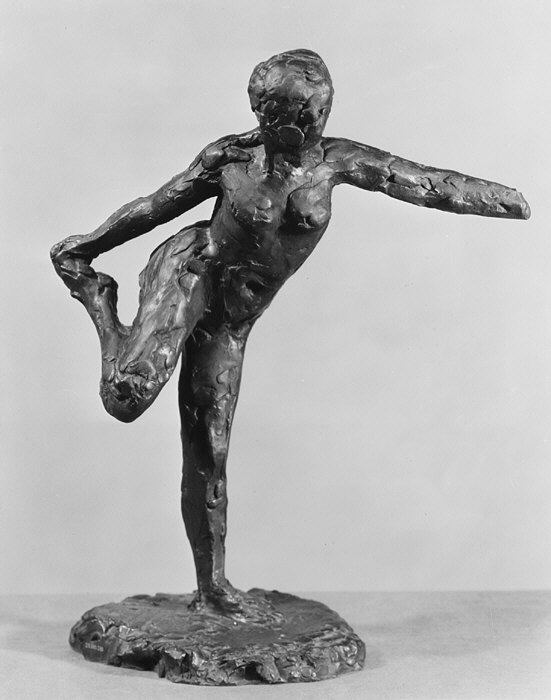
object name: statuette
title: Dancer Holding her Right Foot in Her Right Hand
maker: edgar degas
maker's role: artist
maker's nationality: french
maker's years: 1834-1917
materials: bronze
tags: female nudes,dancers